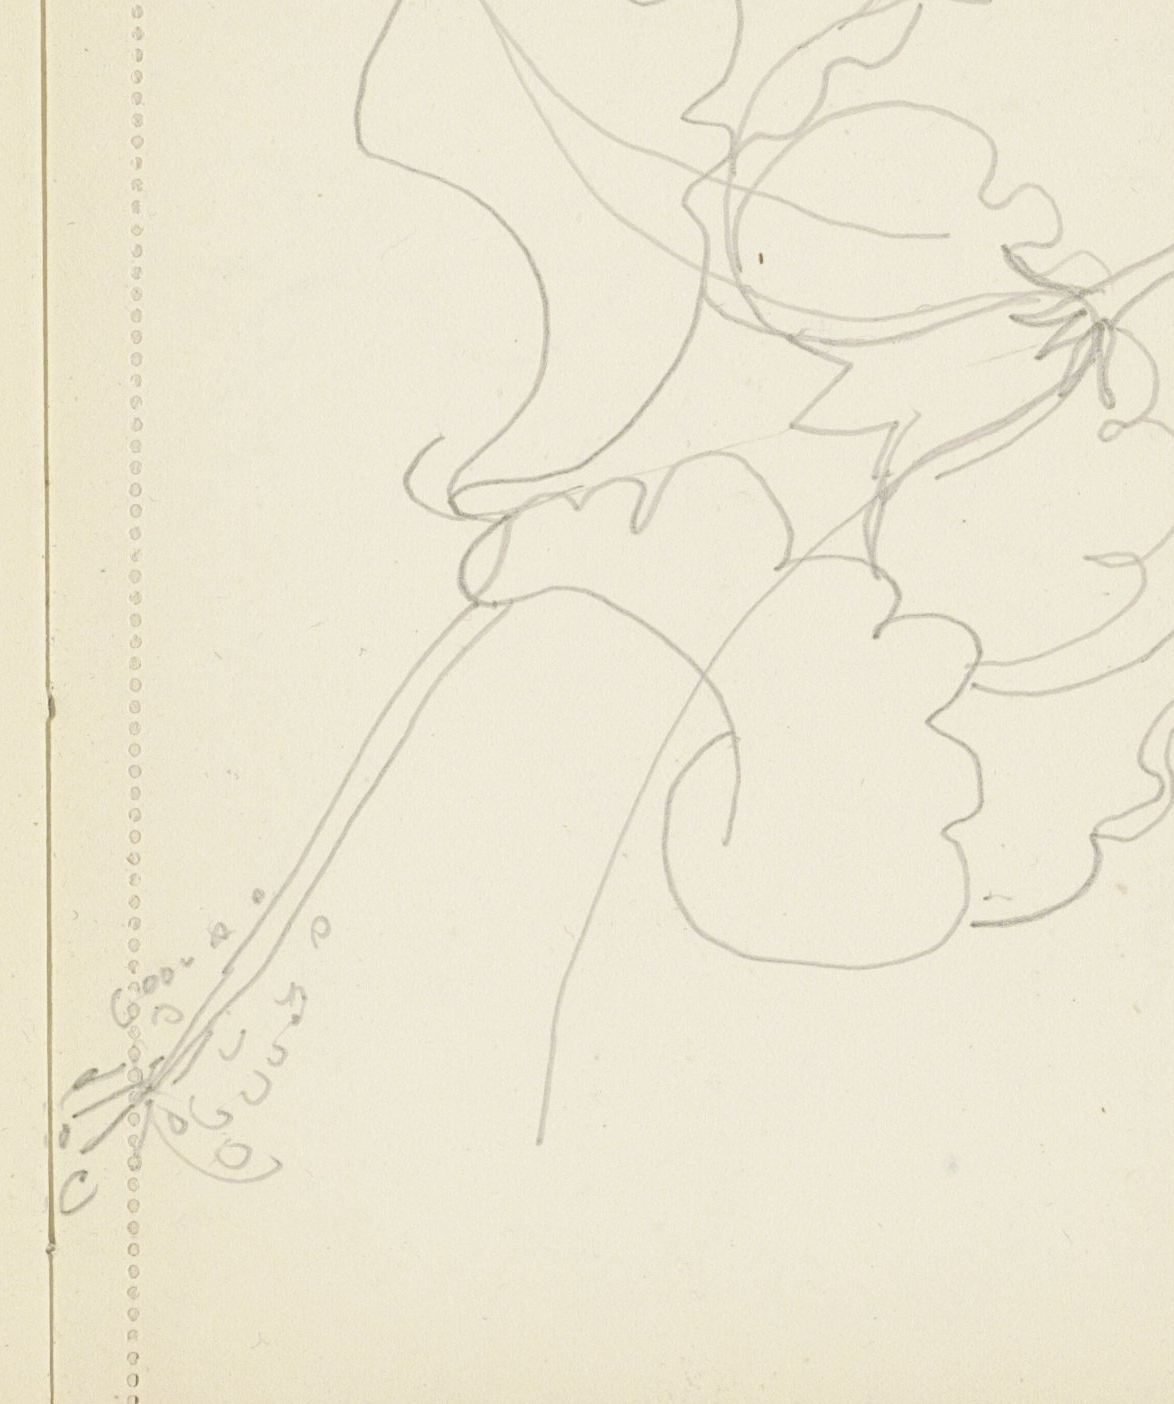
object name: sketchbook leaf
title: Bloem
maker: reijer stolk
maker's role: draughtsman, print maker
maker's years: 1896-1945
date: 1916-1945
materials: paper, pencil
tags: flowers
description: Blad 7 recto uit een schetsboek met 60 bladen.